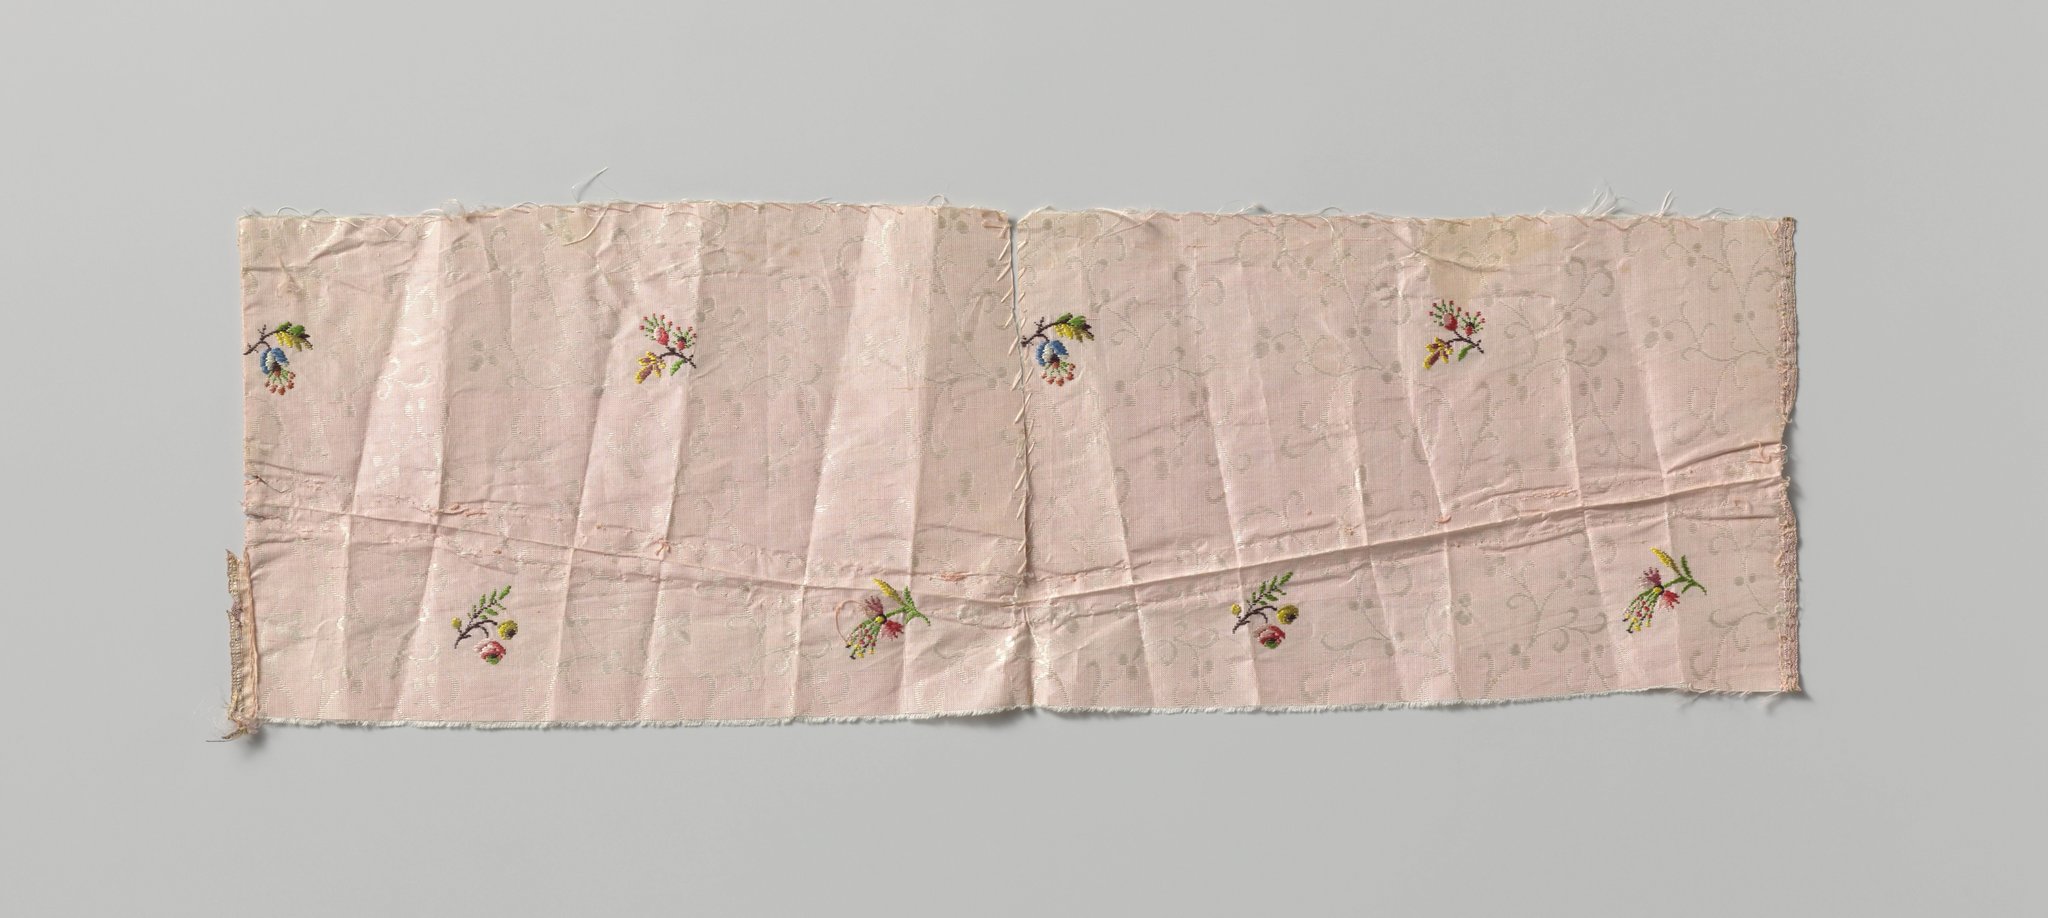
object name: fragment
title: Staal gebrocheerde zijde, roze, met witte ranken en gekleurde bloemen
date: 1750-1800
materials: silk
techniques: brocade, weave